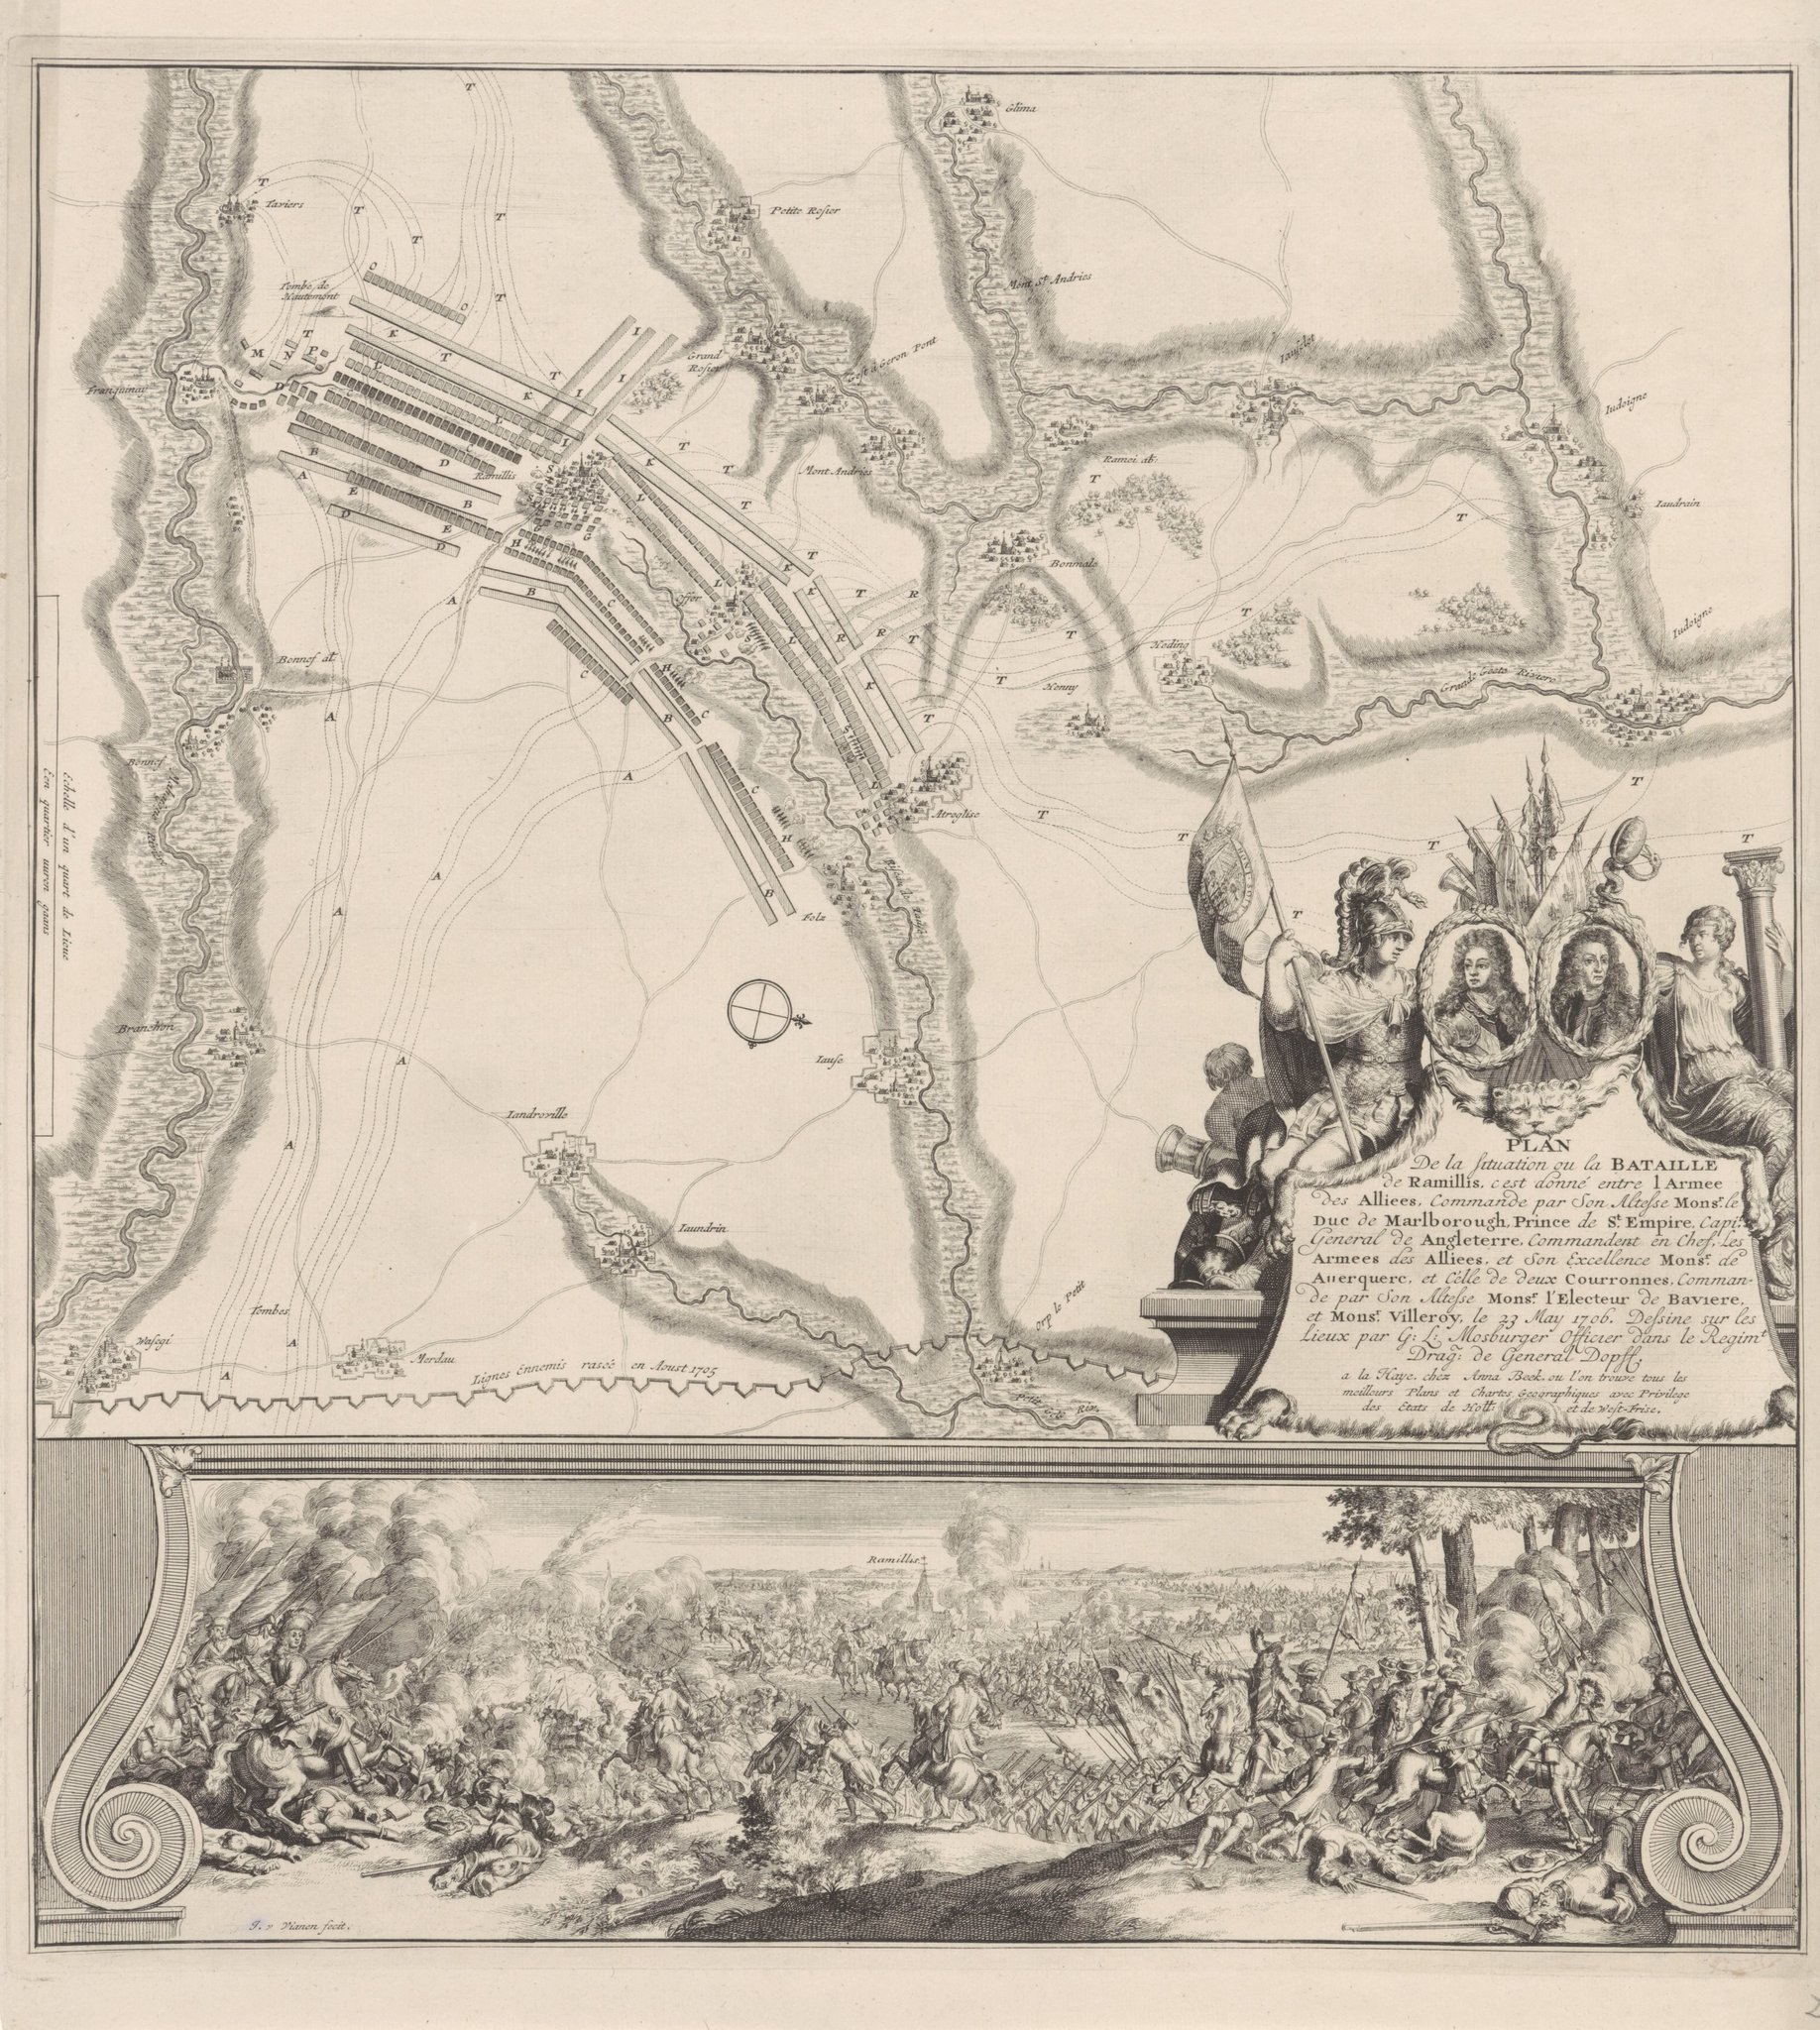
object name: print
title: Landkaart en illustratie van de slag bij Ramillies, 1706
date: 1706-1708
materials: paper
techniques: engraving, etching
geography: the hague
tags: john churchill (1e hertog van marlborough), the hague, maps of separate countries or regions, battle (+ land forces), battle arrays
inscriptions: collector's mark: Lugt 240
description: Plan en gezicht van de slag bij Ramillies tussen de Geallieerden onder de hertog van Marlborough en Hendrik van Nassau, heer van Ouwerkerk en de Fransen en de Beiersen, 23 mei 1706. Rechts een cartouche versierd met allegorische figuren en de portretten van Marlborough en Ouwerkerk. Onderaan is een blad geplakt met de slagorde van de Geallieerden bij de veldslag. Links en rechts een relaas van de slag in het Frans en Nederlands.